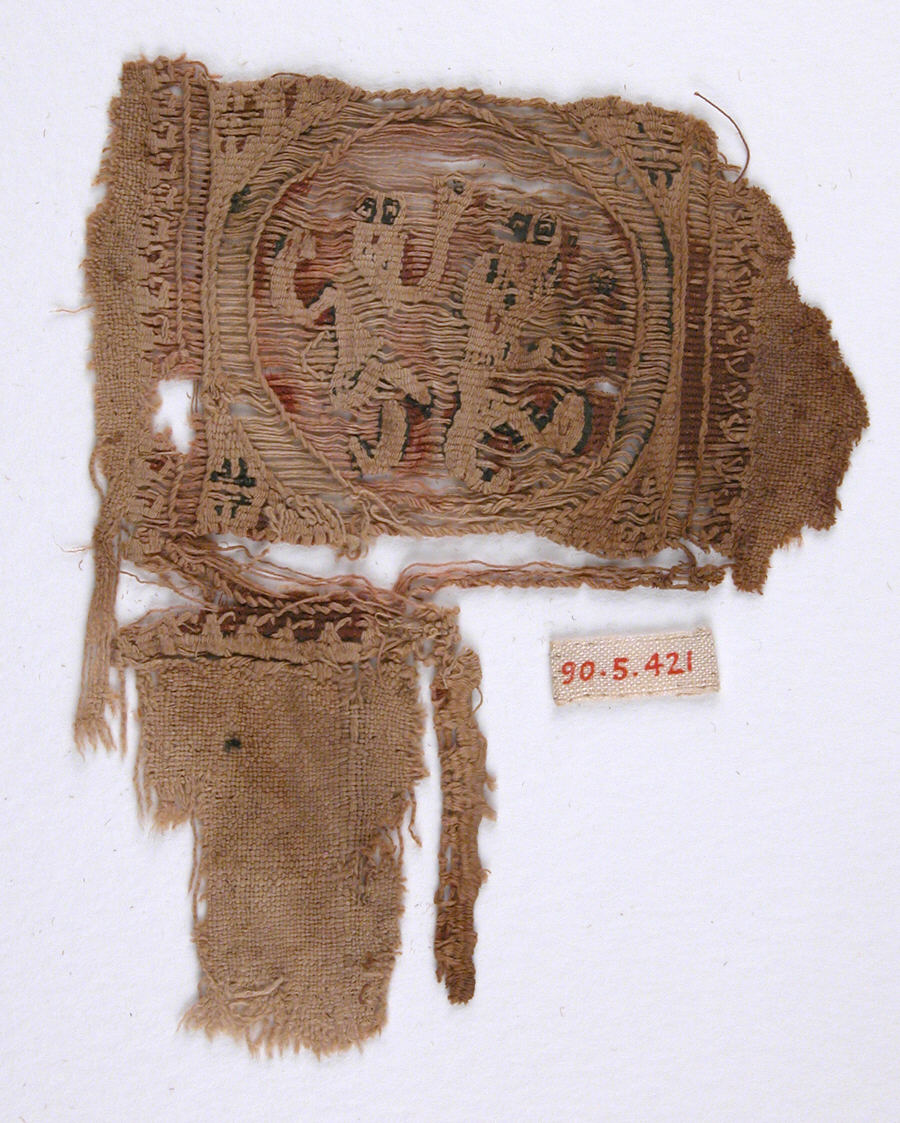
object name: textile fragment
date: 401-500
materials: linen, wool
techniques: weave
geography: egypt